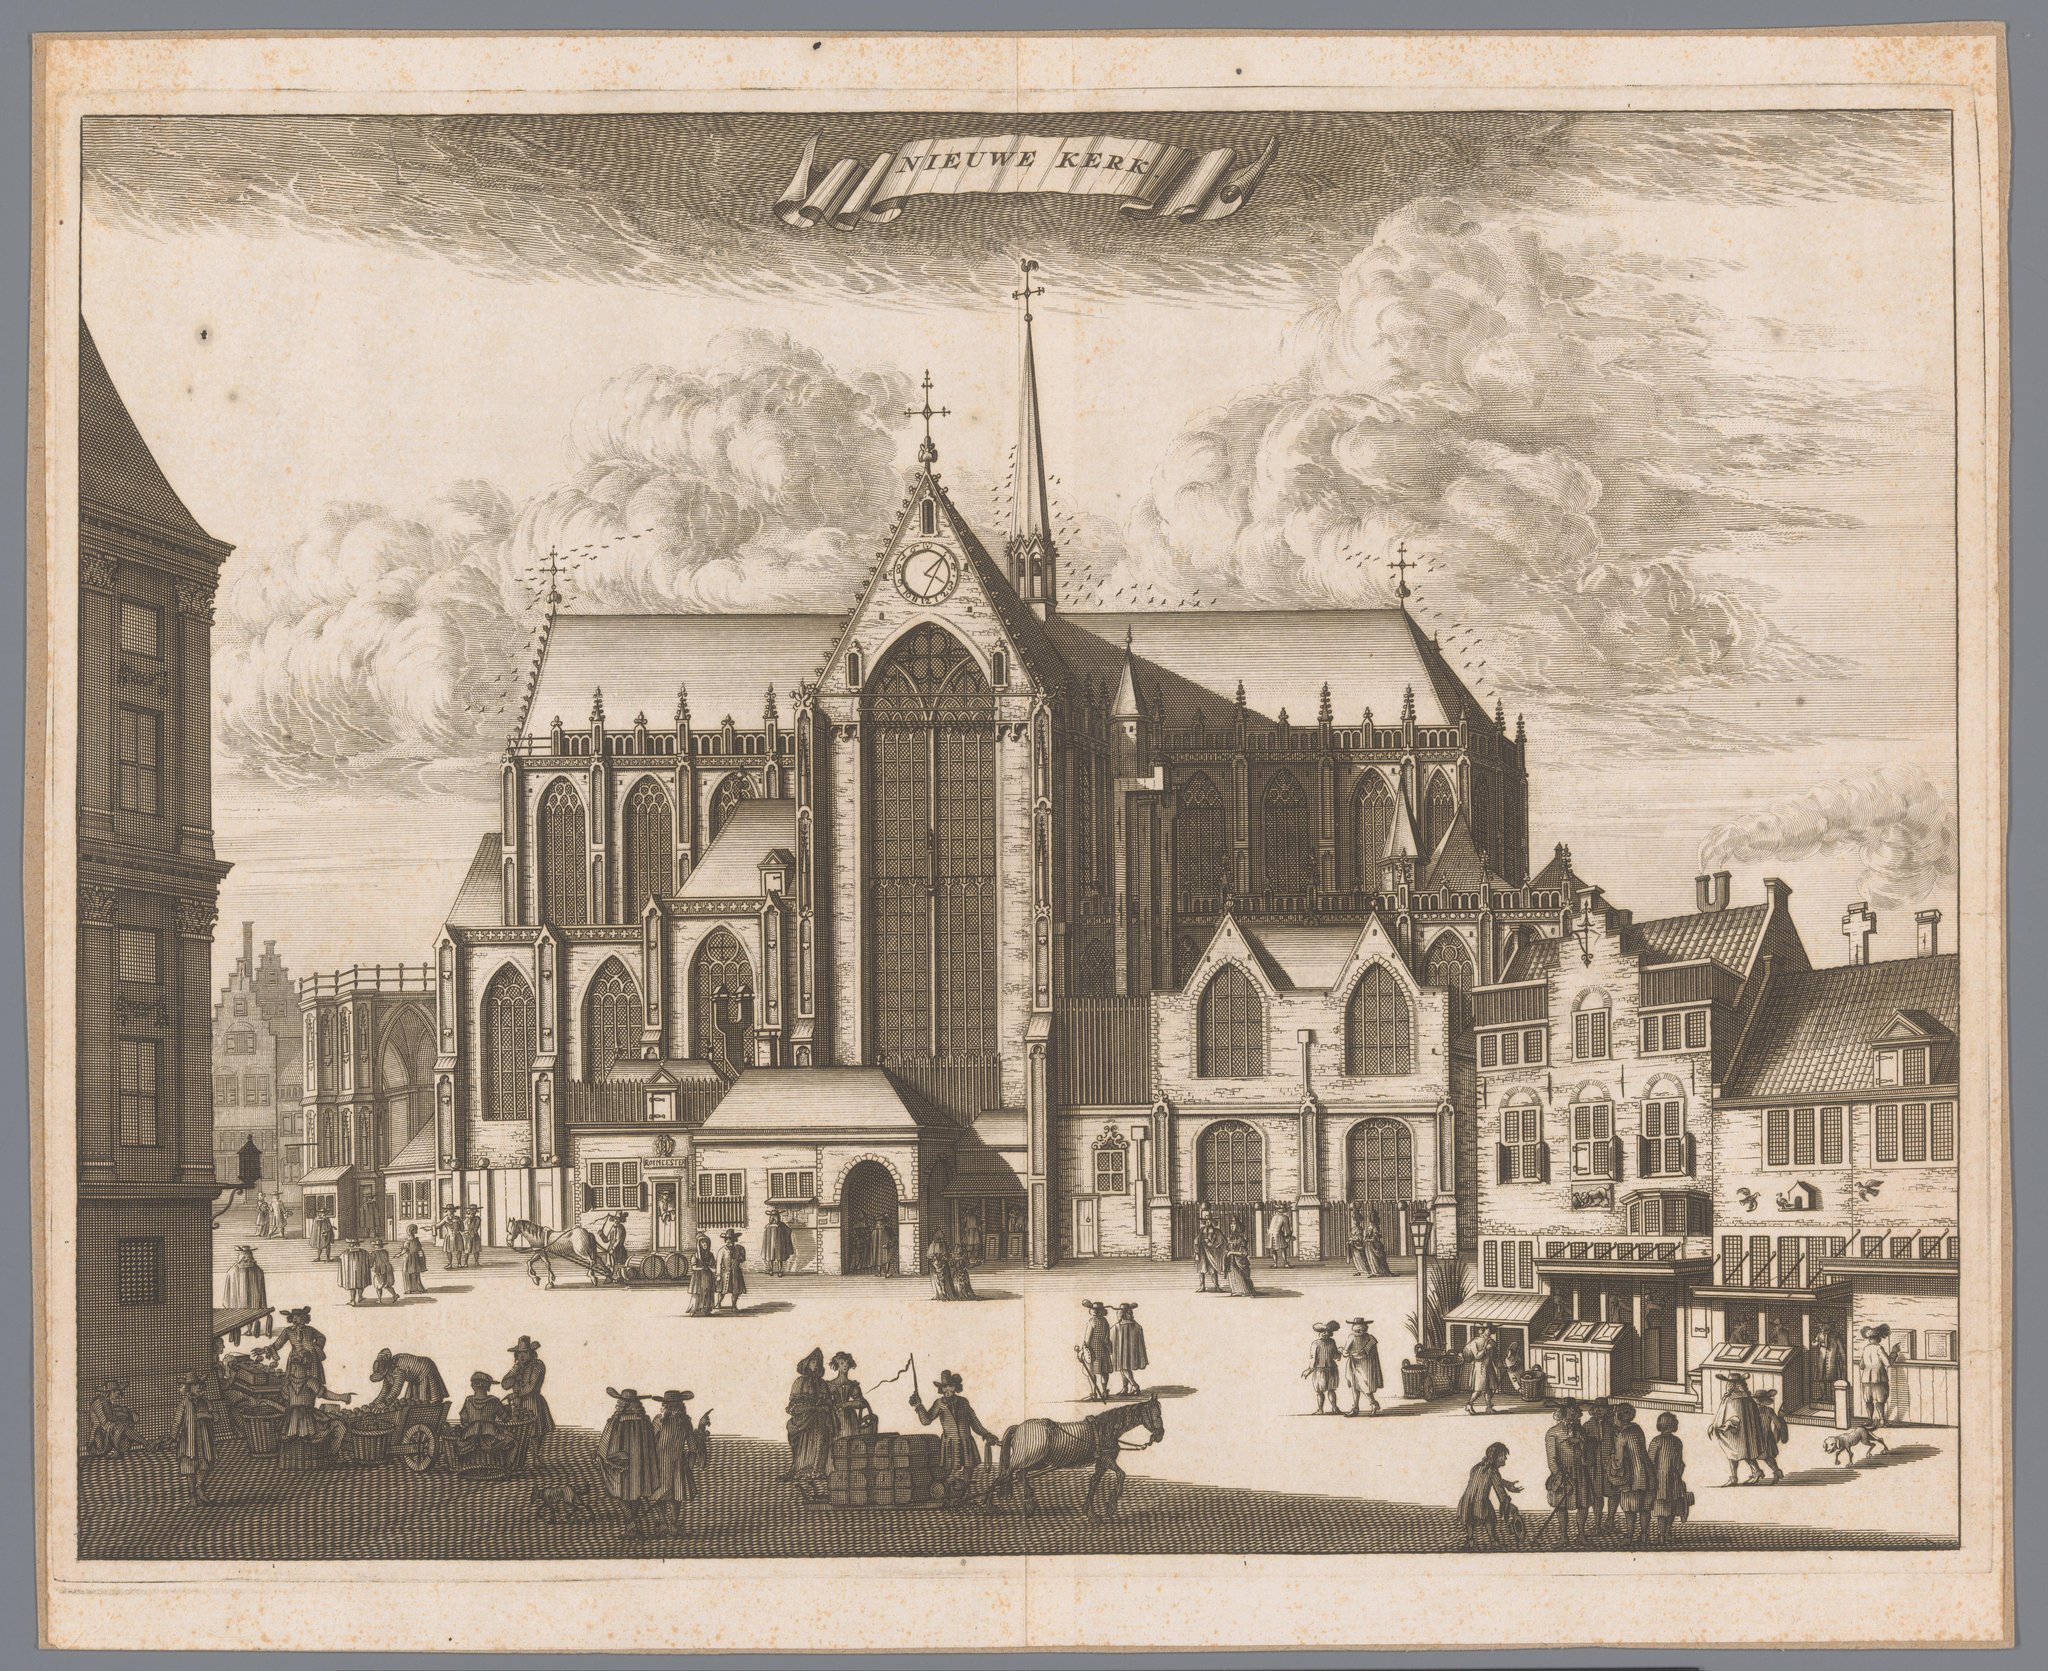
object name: book illustration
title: Gezicht op de Nieuwe Kerk te Amsterdam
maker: Anonymous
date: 1693-1694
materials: paper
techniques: etching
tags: church (exterior), square, place, circus, etc. (+ city(-scape) with figures, staffage)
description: Prent uit: Commelin, Caspar. Beschryvinge van Amsterdam, desselfs eerste oorspronk uyt den Huyse (…). Amsterdam: Abraham Wolfgang, et al., 1693, tussen p. 444 en 445. Of uit: Commelin, Caspar. Beschryvinge van Amsterdam, zynde een naukeurige verhandelinge van desselfs eerste oorspronk uyt (…). Amsterdam: weduwe Aart Dircksz Oossaan, 1694, tussen p. 444 en 445. Latere staat van prent is gebruikt in: Commelin, Caspar. Beschryvinge van Amsterdam, zynde een naukeurige verhandelinge van desselfs eerste oorspronk uyt (…). Amsterdam: Andries van Damme et al., 1726.